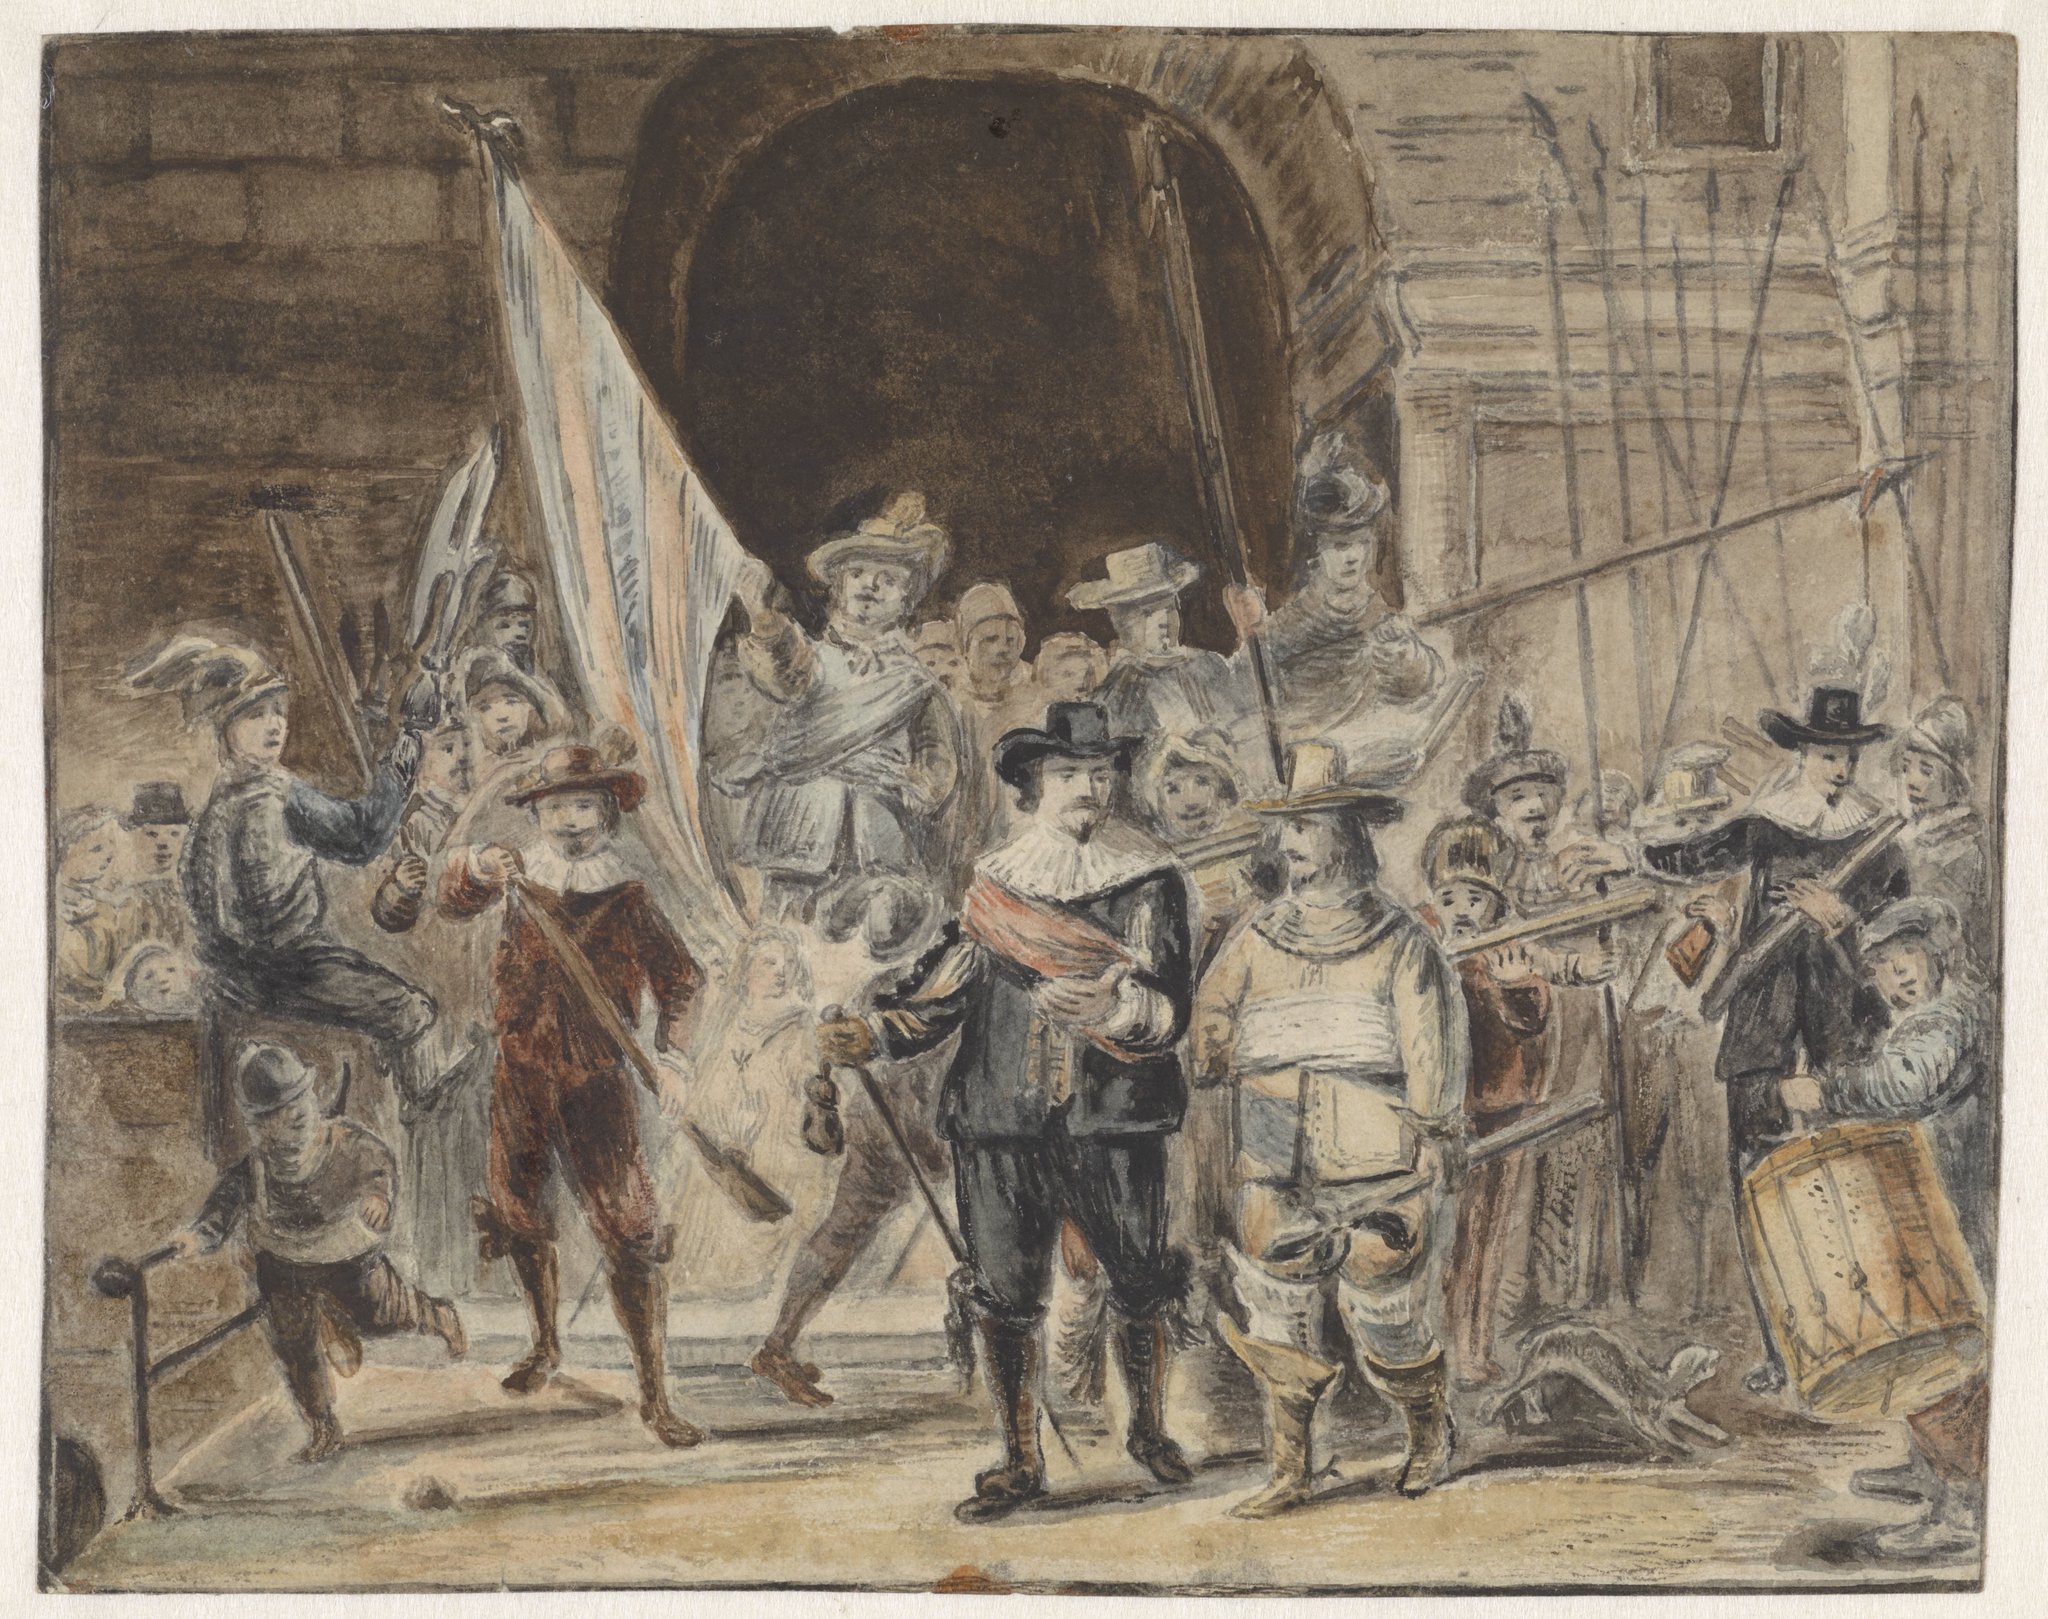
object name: drawing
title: De Nachtwacht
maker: johannes dyserinck (dr.)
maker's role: draughtsman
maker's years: 1835-1912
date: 1845-1912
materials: paper, pencil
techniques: brush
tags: mayor, frans banninck cocq, names of artefacts and man-made objects (buildings excluded), historical persons, picture, painting